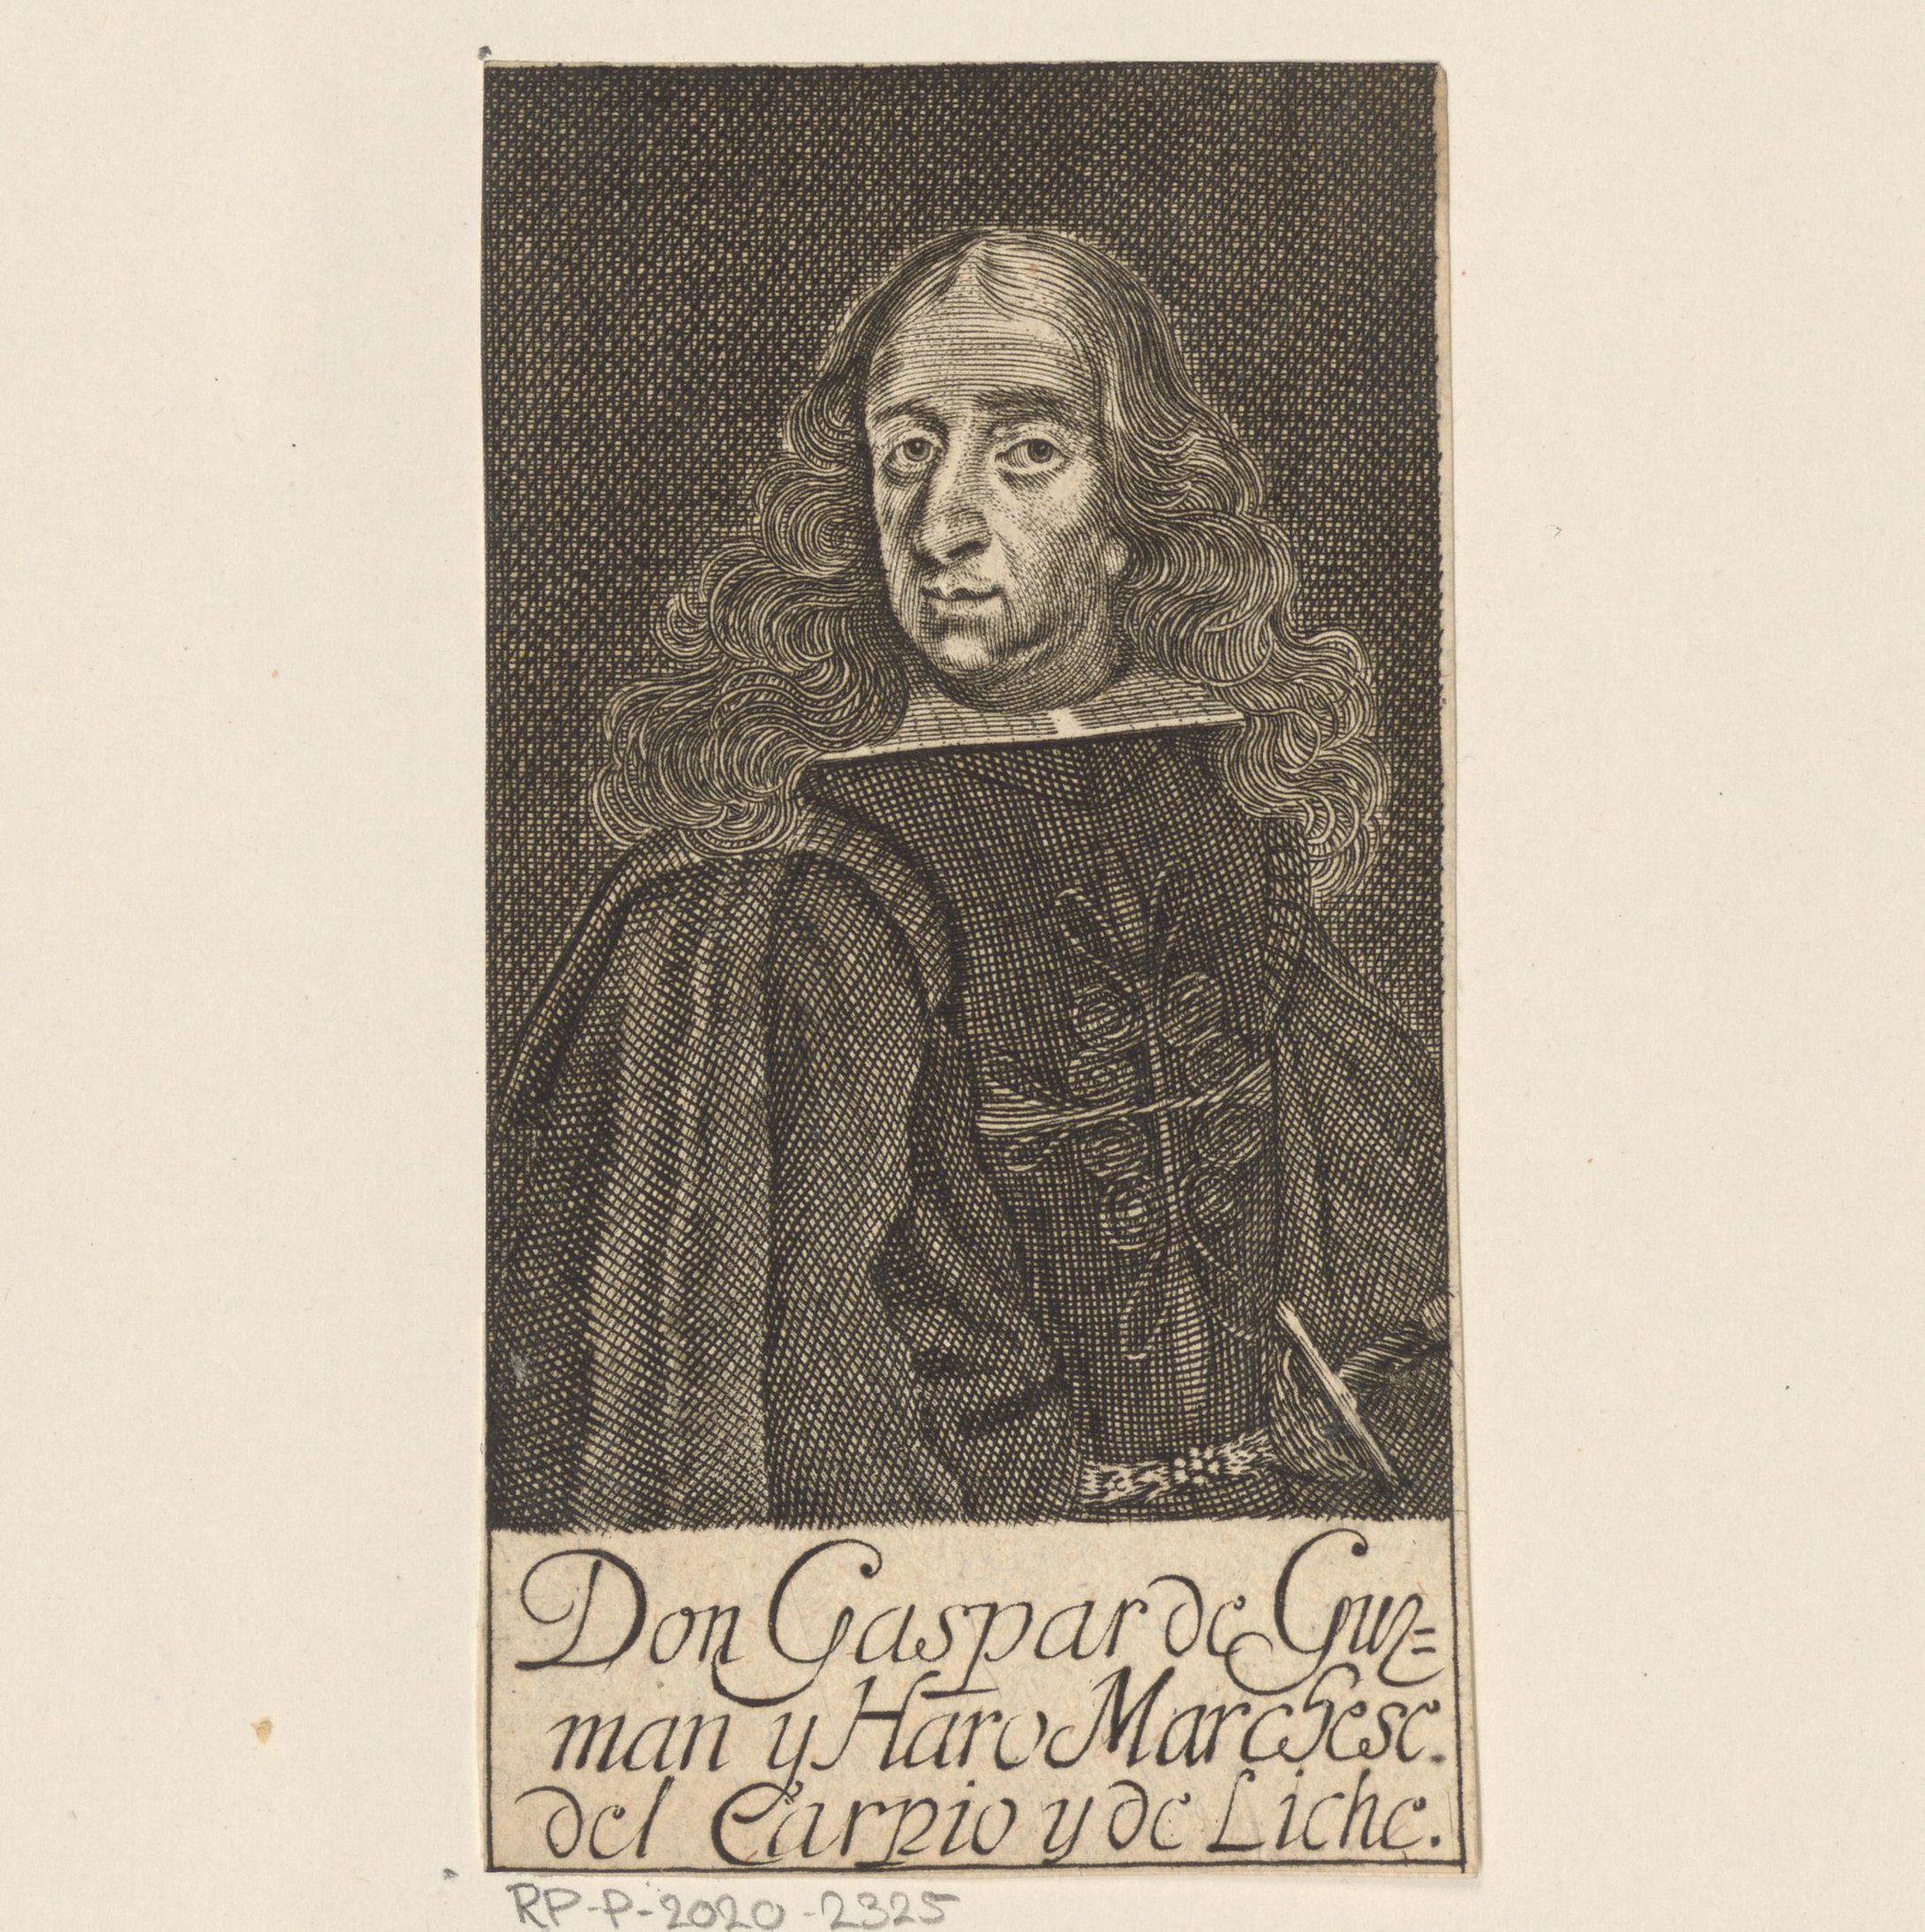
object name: print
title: Portret van Don Gaspar de Guzman, Marchese del Carpio y de Liche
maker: Anonymous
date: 1703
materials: paper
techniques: engraving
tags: gaspar de haro y guzmán (markies van carpio en liche), historical persons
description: Prent mogelijk uit: Jumel de Barneville d' Aulnoy, Marie Catherine le. Spanische Staats-Geschichte beschrieben von der Gräfin d'Aunoy (...). Leipzig: Thomas Fritsch, 1703, p. 416.